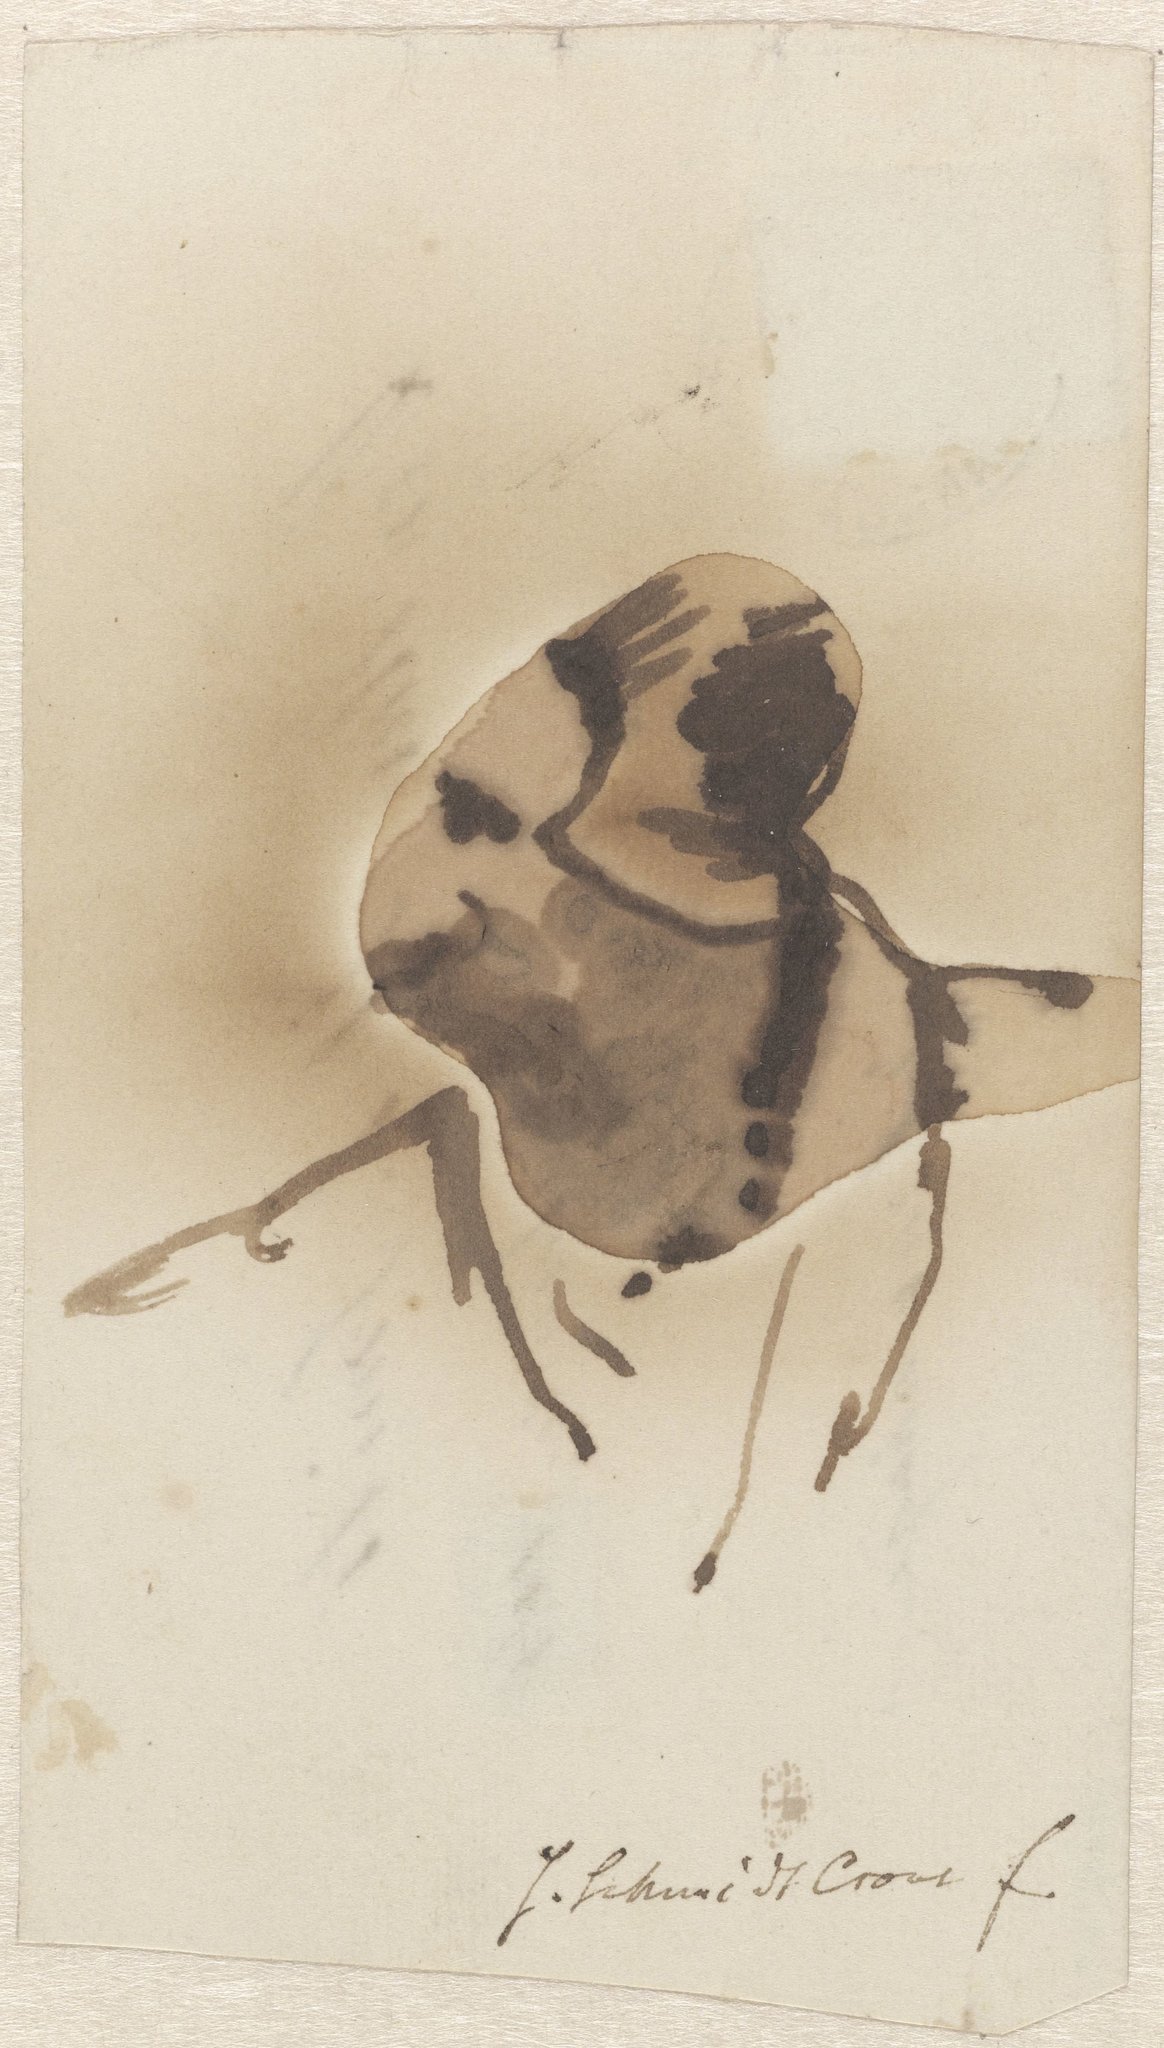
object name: drawing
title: Hoofd van een man, naar links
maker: johan michaël schmidt crans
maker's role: draughtsman, print maker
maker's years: 1830-1907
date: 1840-1907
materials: paper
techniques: brush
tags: anonymous historical person portrayed alone